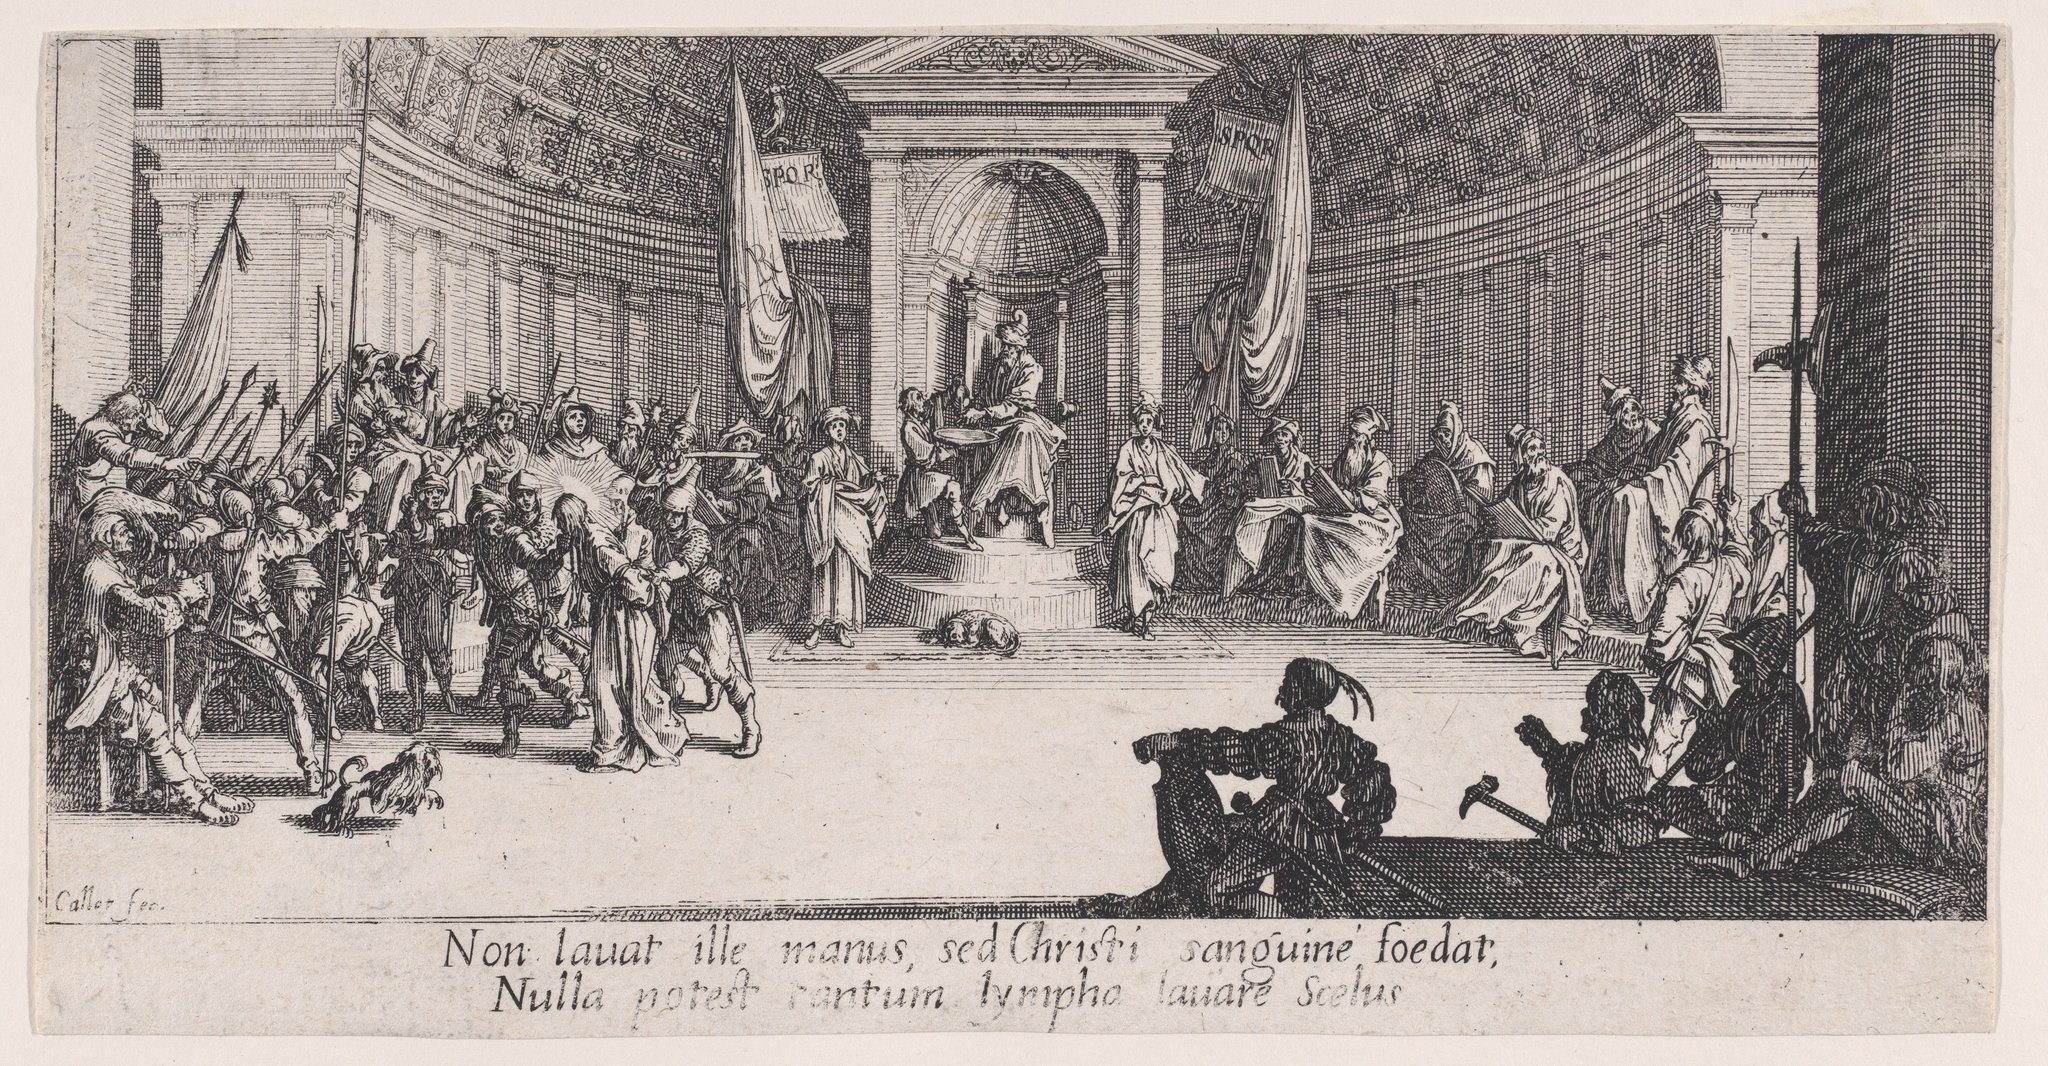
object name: print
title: La Condamnation a Mort (The Condemnation to Death), from "La Grande Passion" (The Large Passion)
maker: jacques callot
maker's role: artist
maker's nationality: french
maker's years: 1592-1635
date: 1619-1624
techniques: engraving, etching